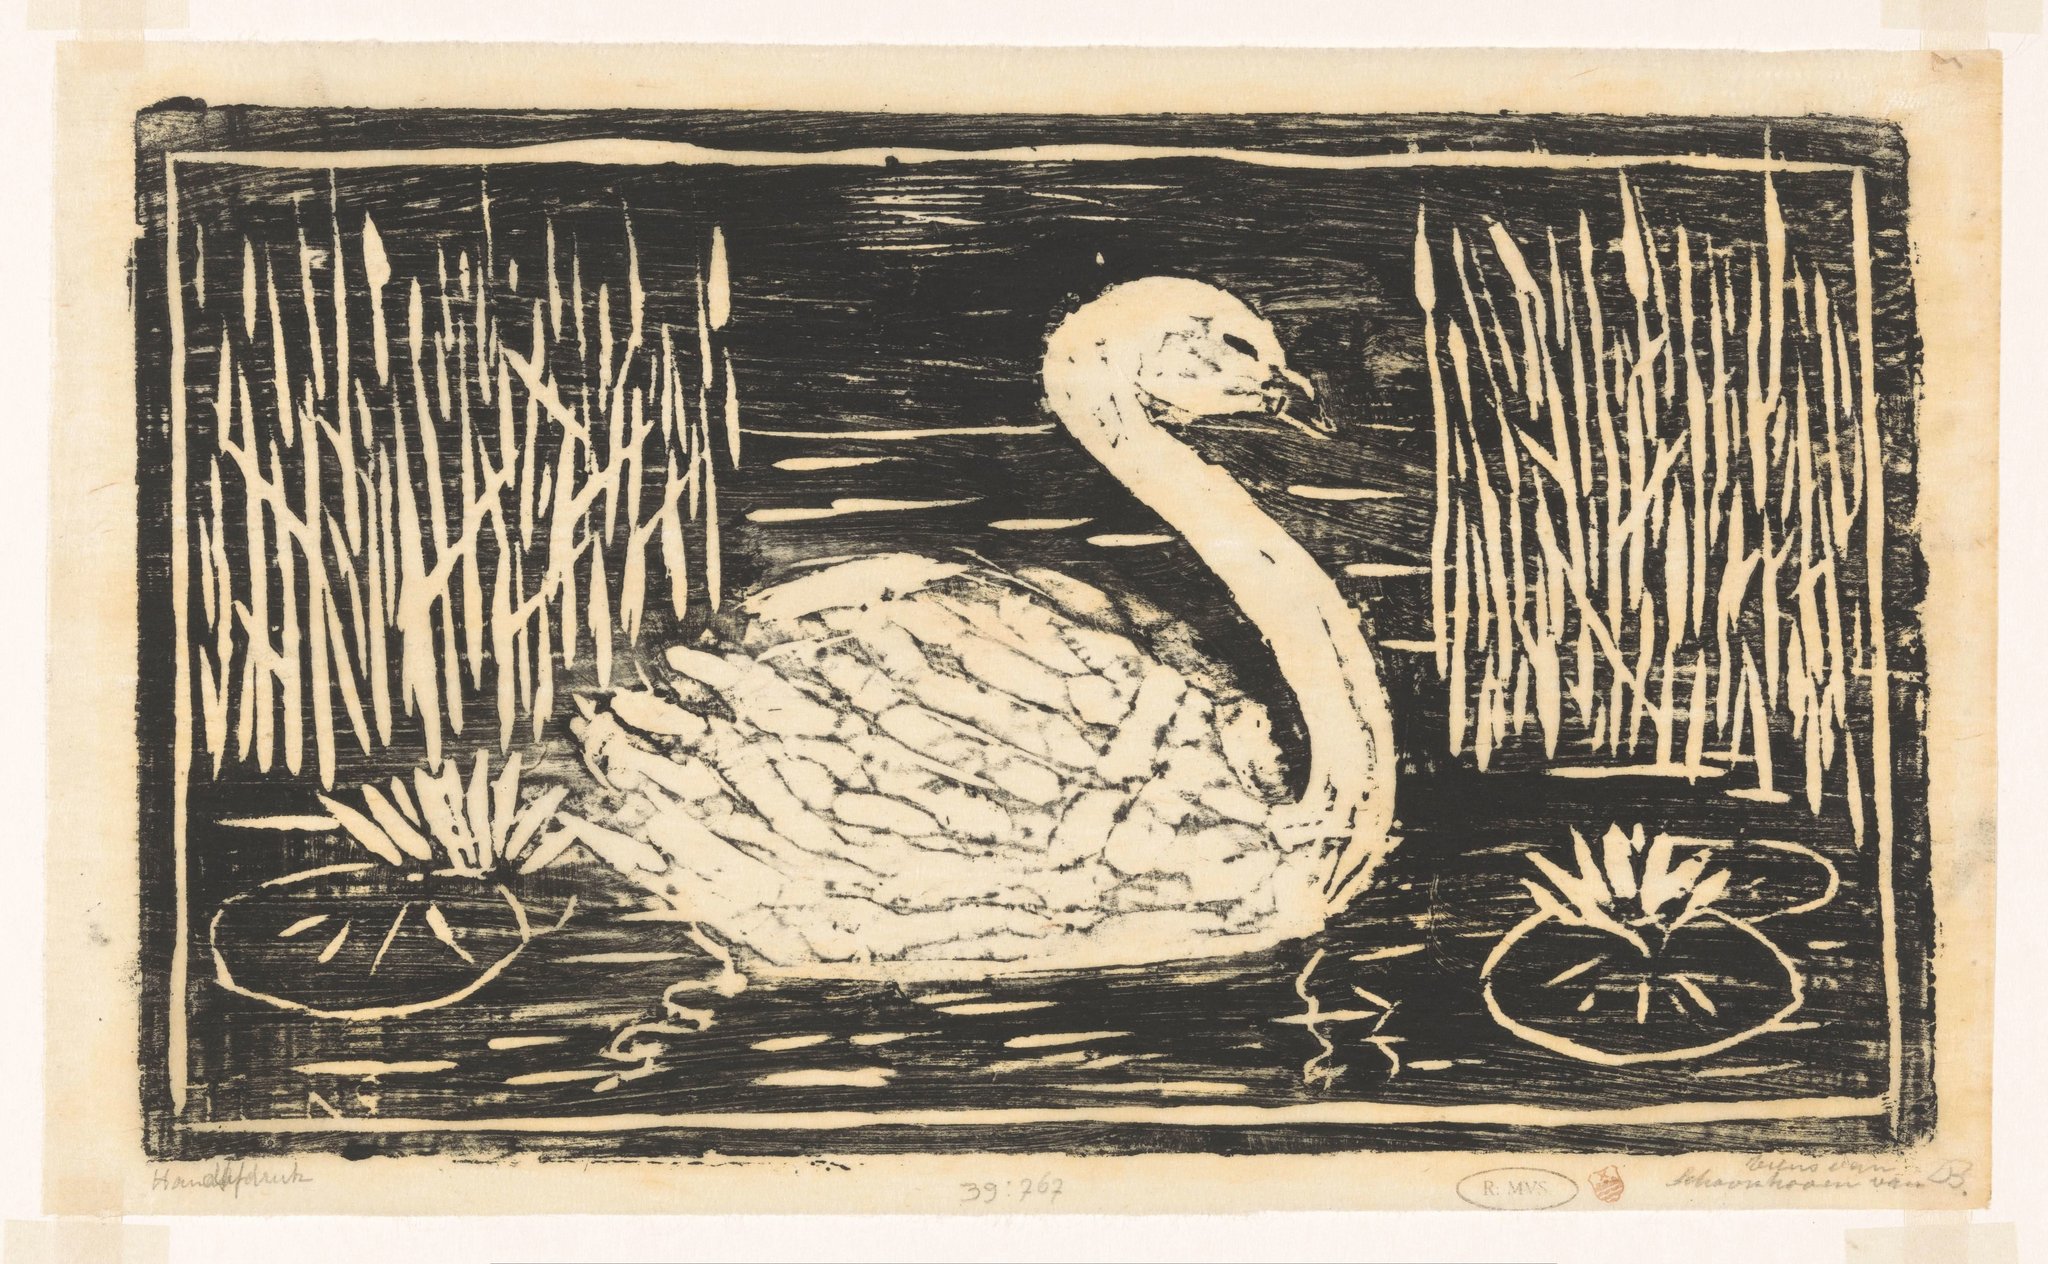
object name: print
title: Zwemmende zwaan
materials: paper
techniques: woodcut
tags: water-birds: swan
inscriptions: collector's mark: Lugt 2760, collector's mark: Lugt 2228